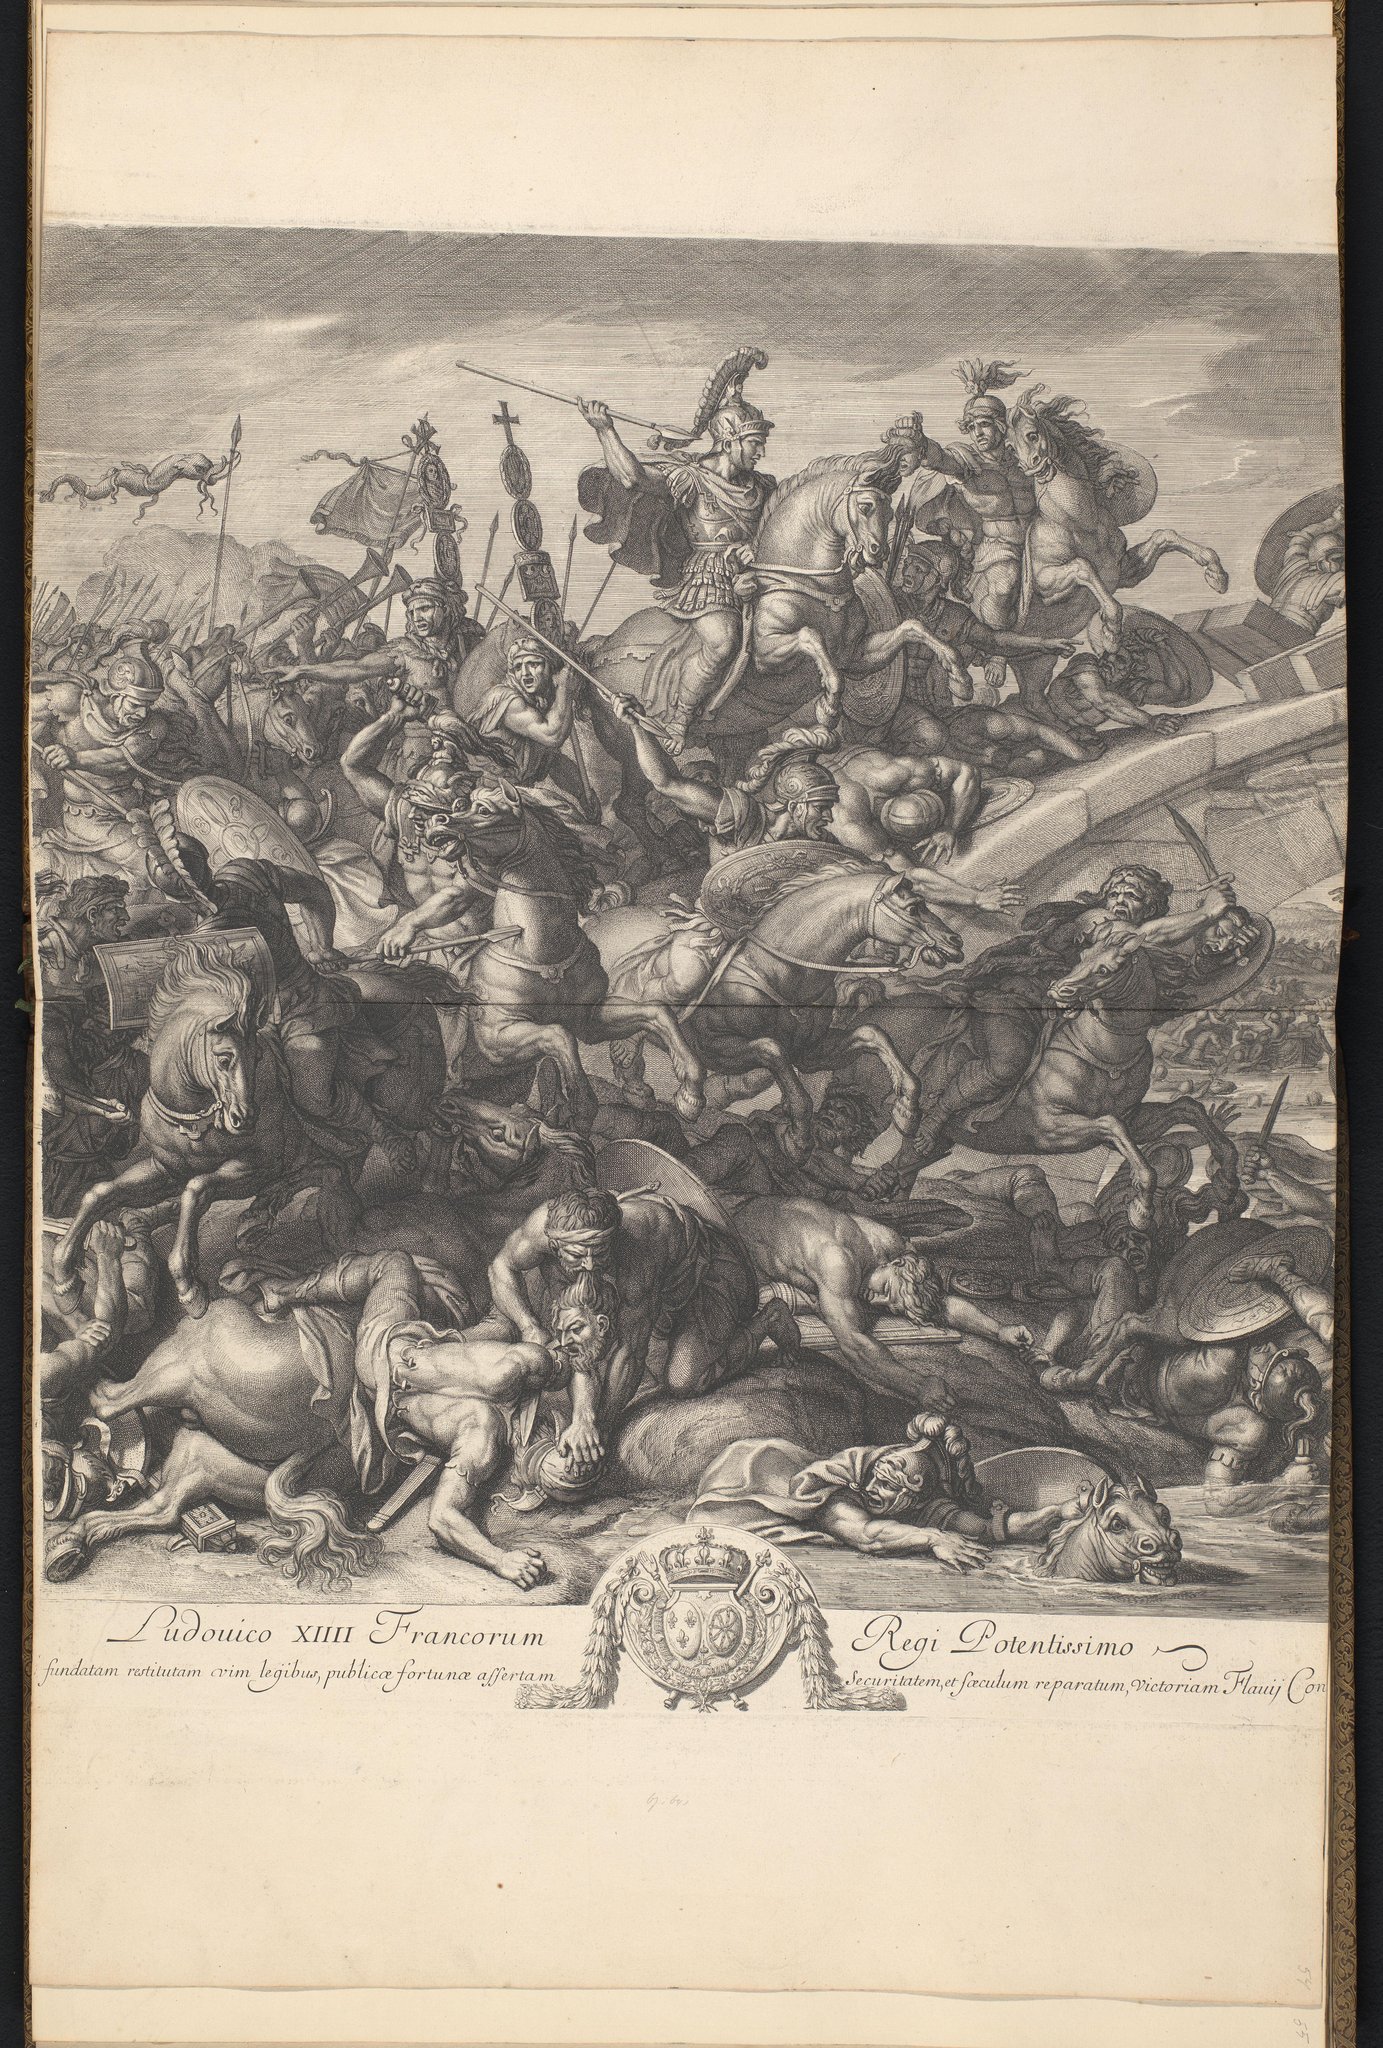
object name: album leaf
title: Werken van Charles le Brun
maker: gérard audran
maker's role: print maker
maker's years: 1640-1703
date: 1666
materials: paper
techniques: engraving, etching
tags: the battle of the milvian bridge (saxa rubra): st. constantine on horseback confronts maxentius; a cross appears in the sky with in fiery letters 'in hoc signo vinces' (the raised standards of the roman soldiers carry a cross or the chi-rho monogram), rome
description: Middelste deel van een prent gedrukt van drie platen.